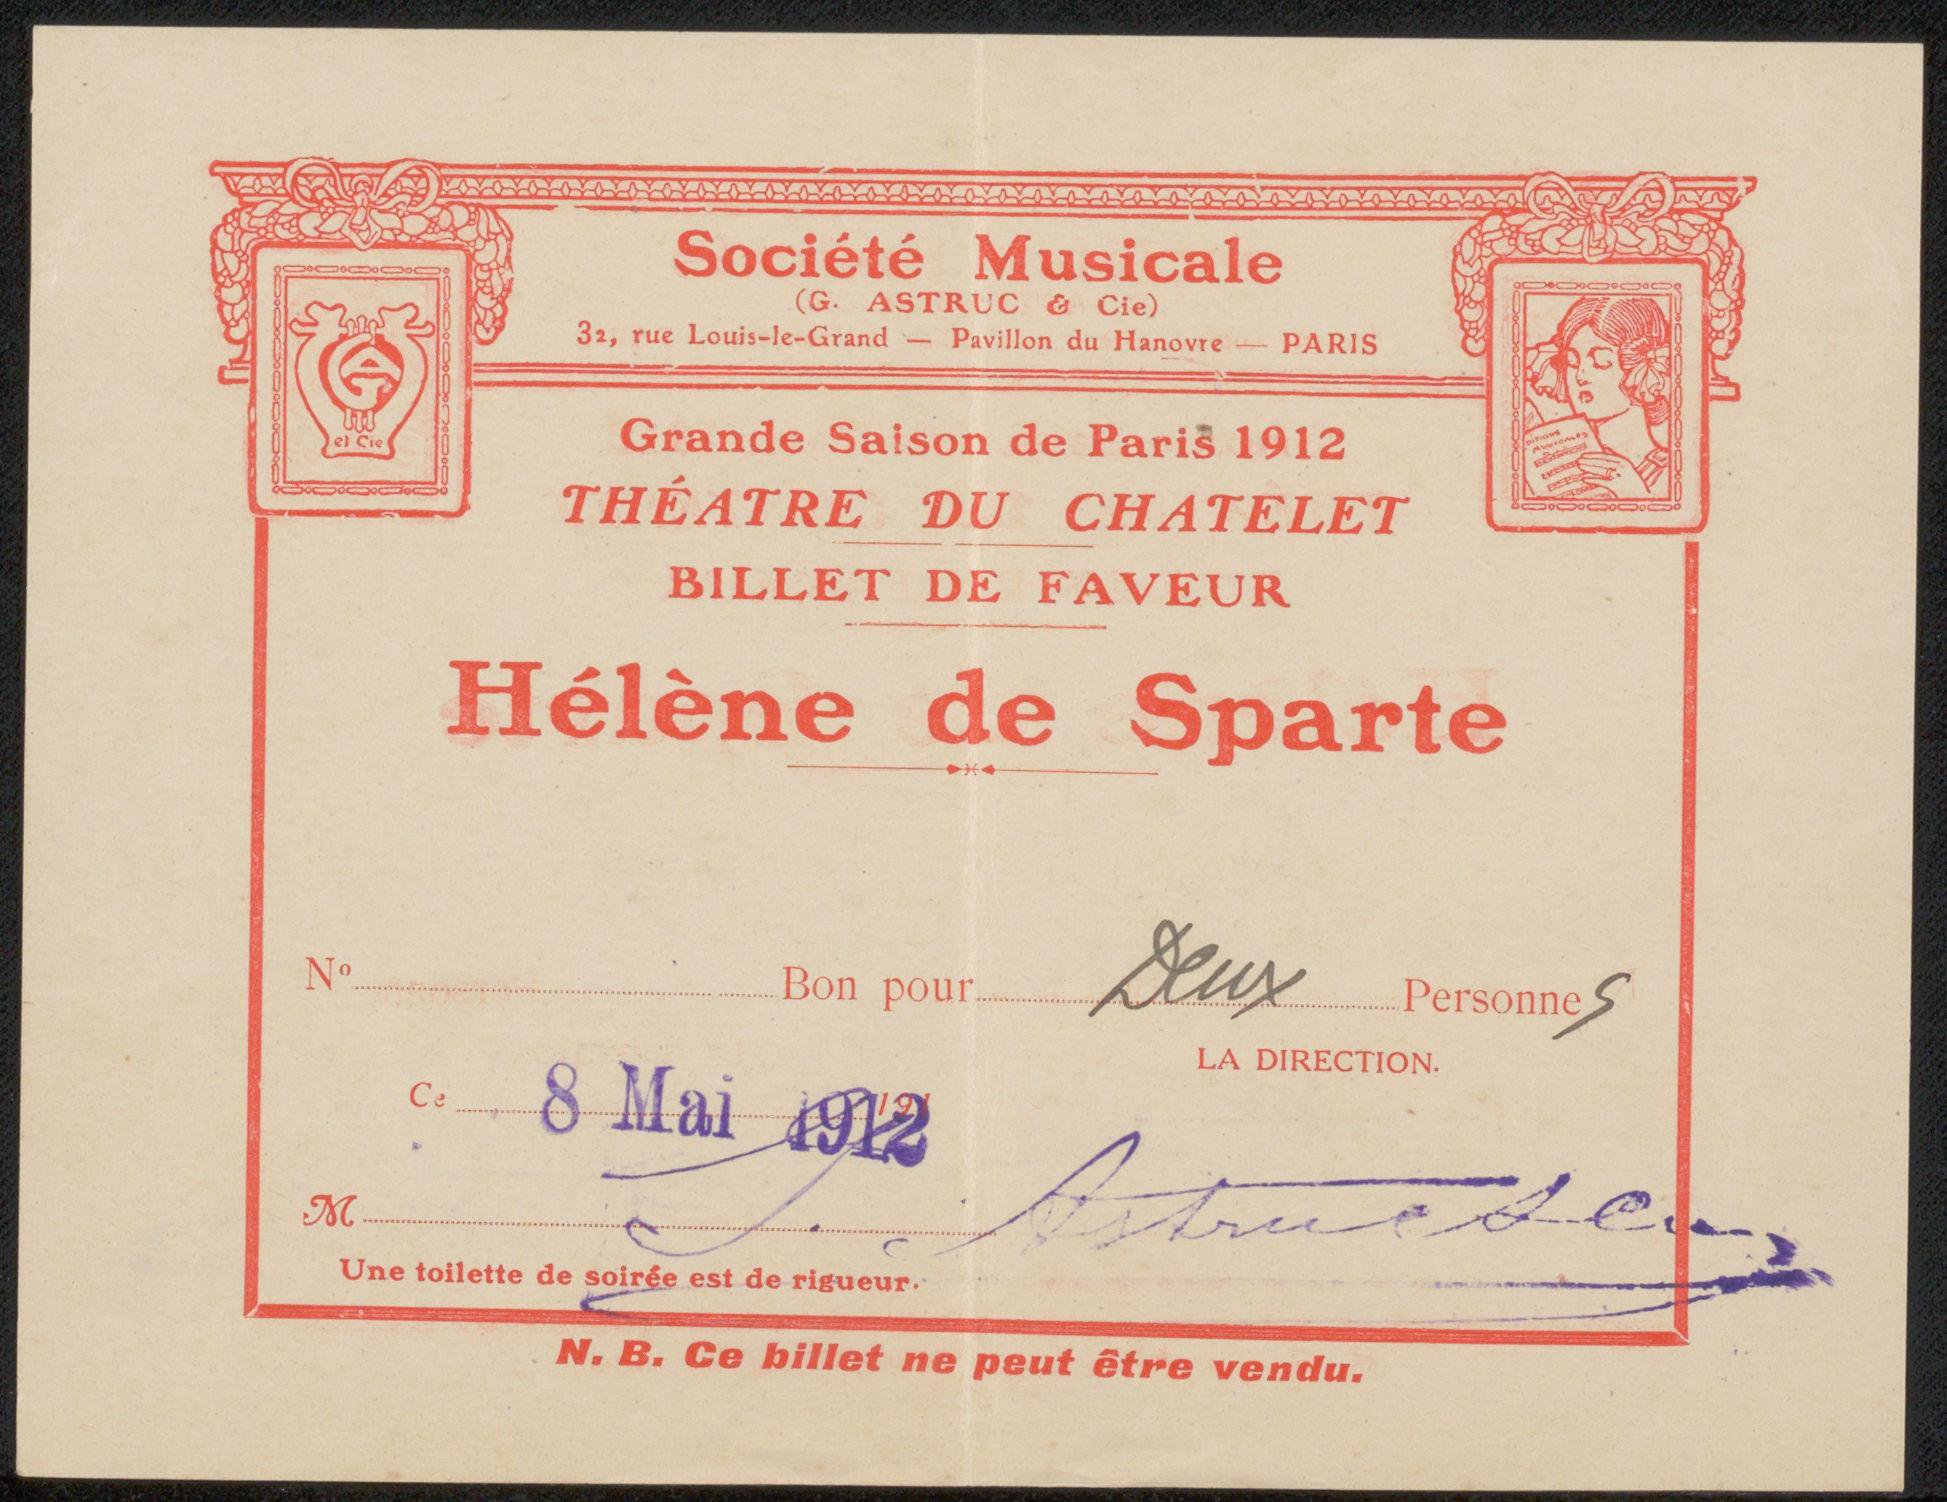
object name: admission ticket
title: Toegangskaart uit archief Philip Zilcken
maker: Anonymous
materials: cardboard, ink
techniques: printing, pen, writing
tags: the hague, painter, draughtsman, philip zilcken, paris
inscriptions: collector's mark: ‘RPK’